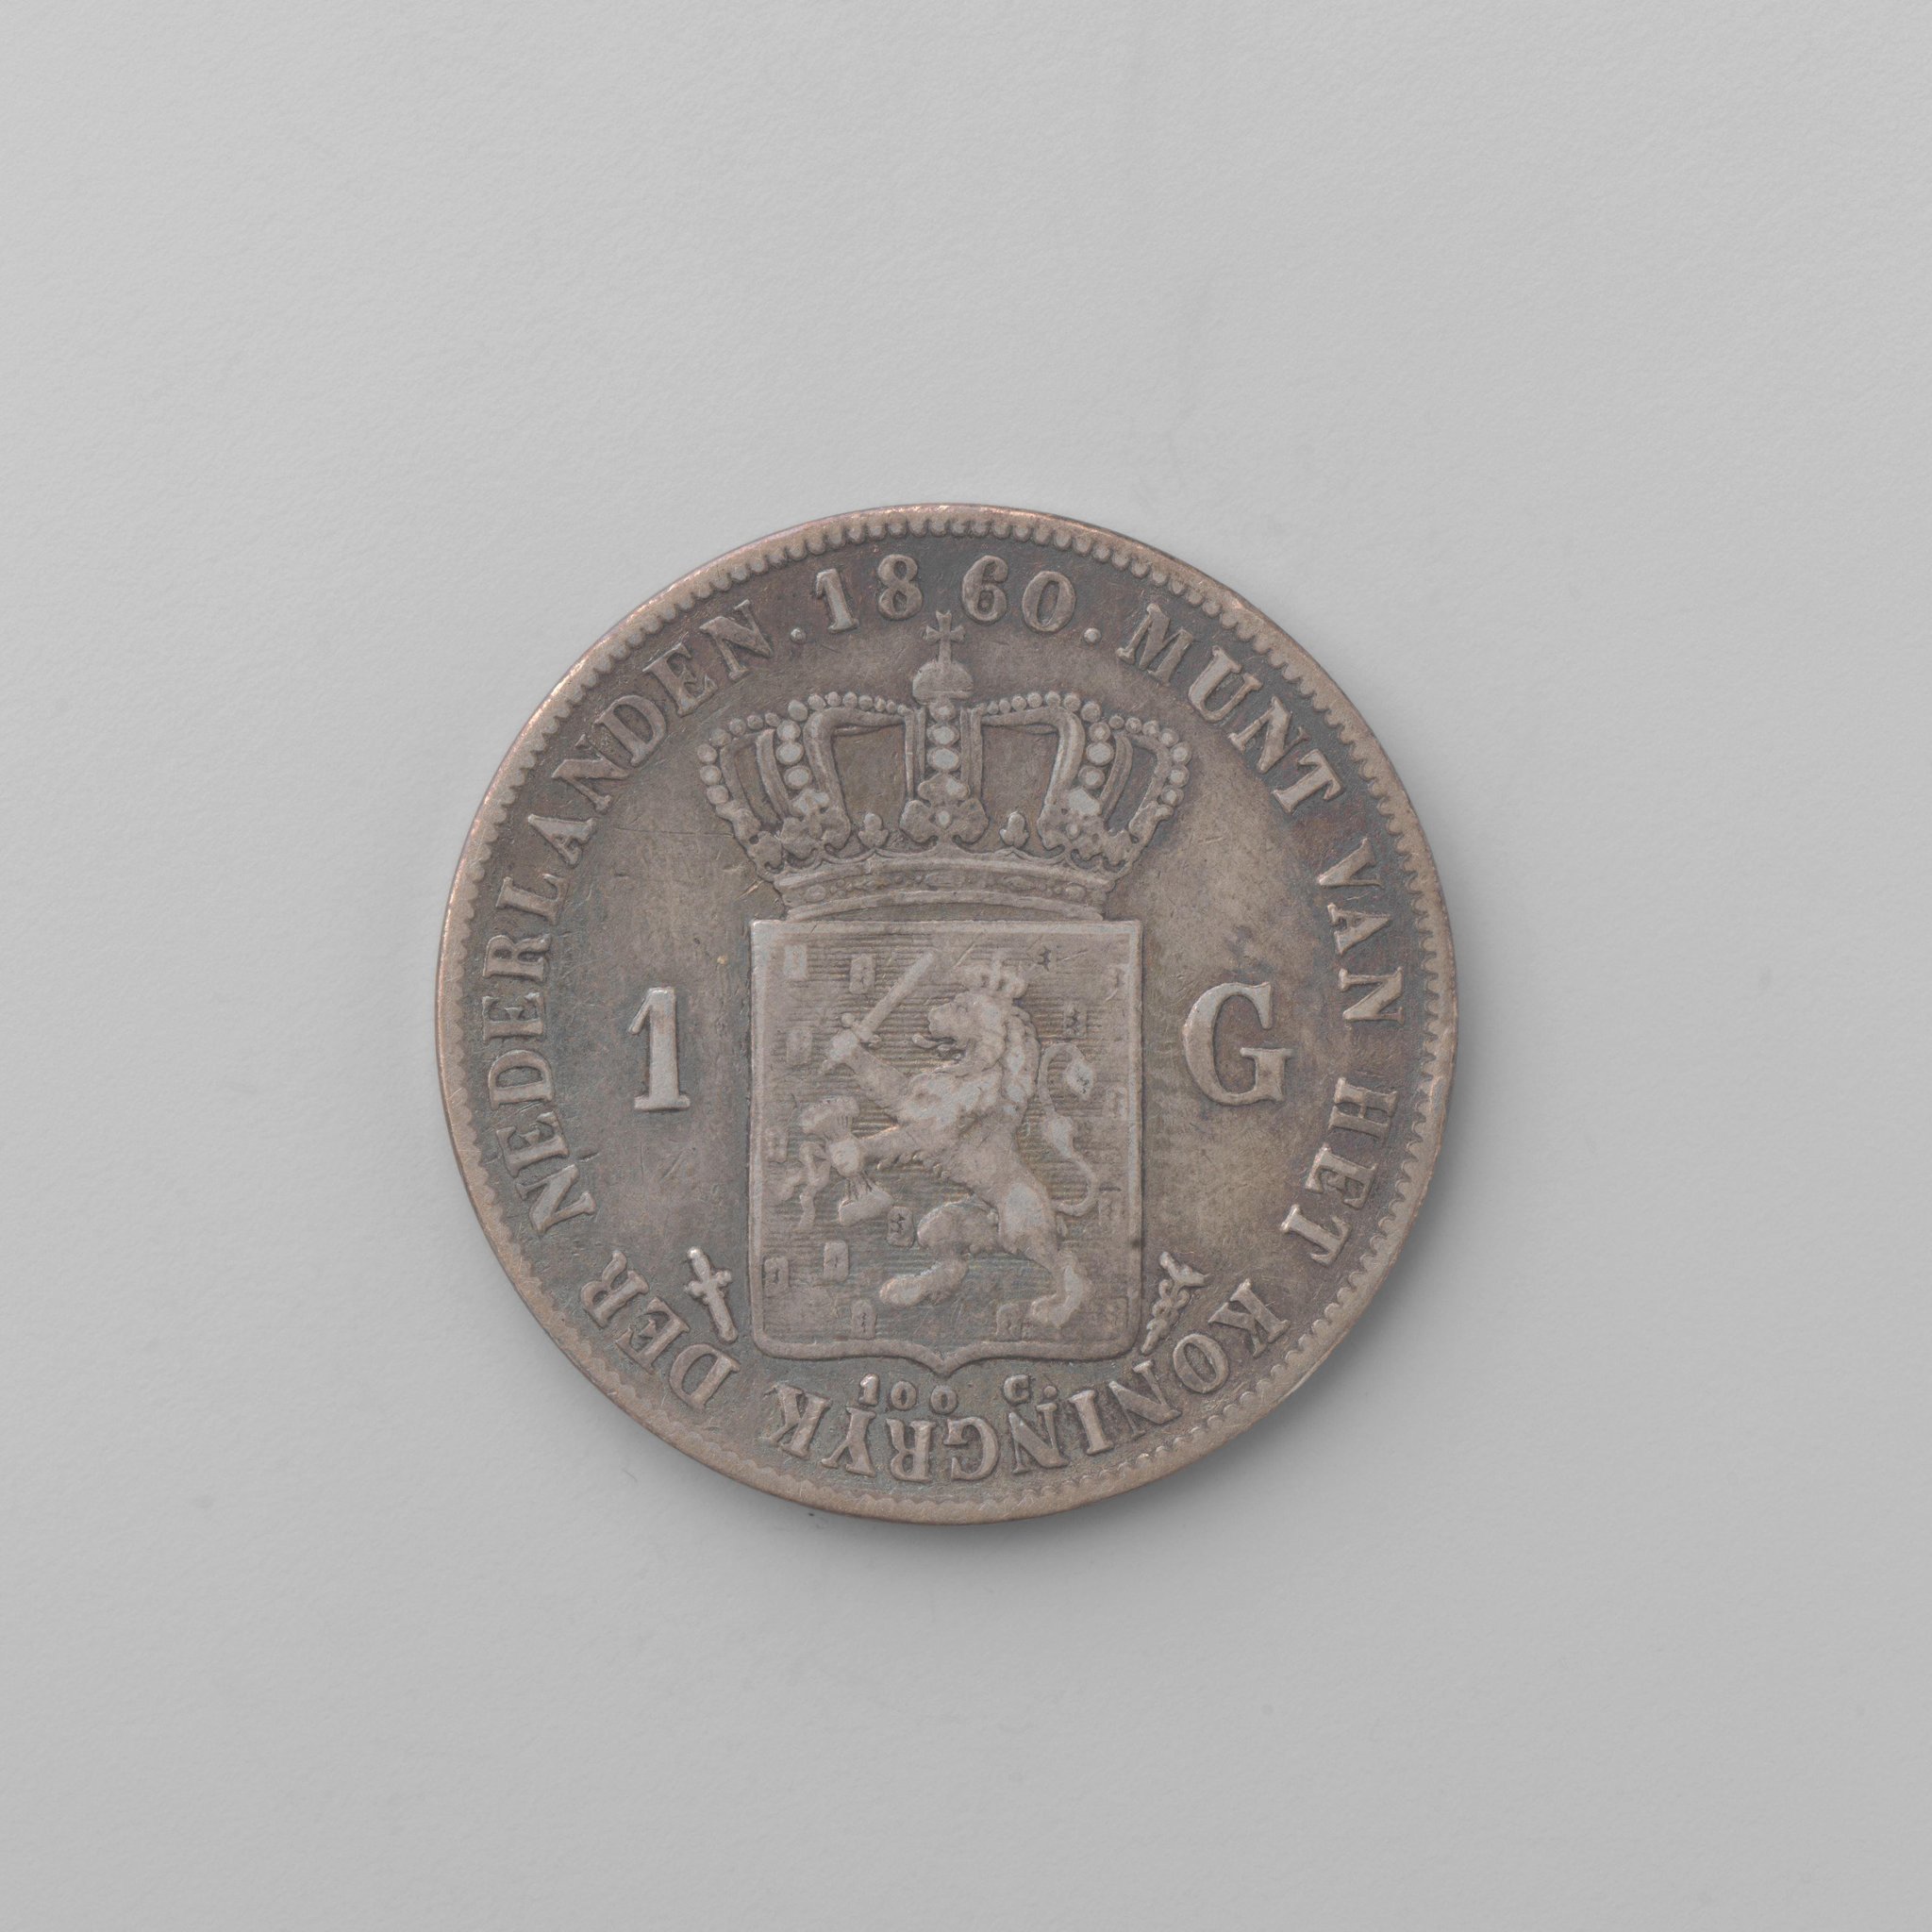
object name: coin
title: Nederlandse gulden, 1860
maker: willem iii (koning der nederlanden)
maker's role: koning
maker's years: 1817-1890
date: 1860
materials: silver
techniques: striking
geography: utrecht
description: Zilveren munt. Voorzijde: borstbeeld naar rechts. Keerzijde: tussen waarde-aanduiding 1 G gekroond rijkswapenschild. Jaartal boven kroon. Randschrift.